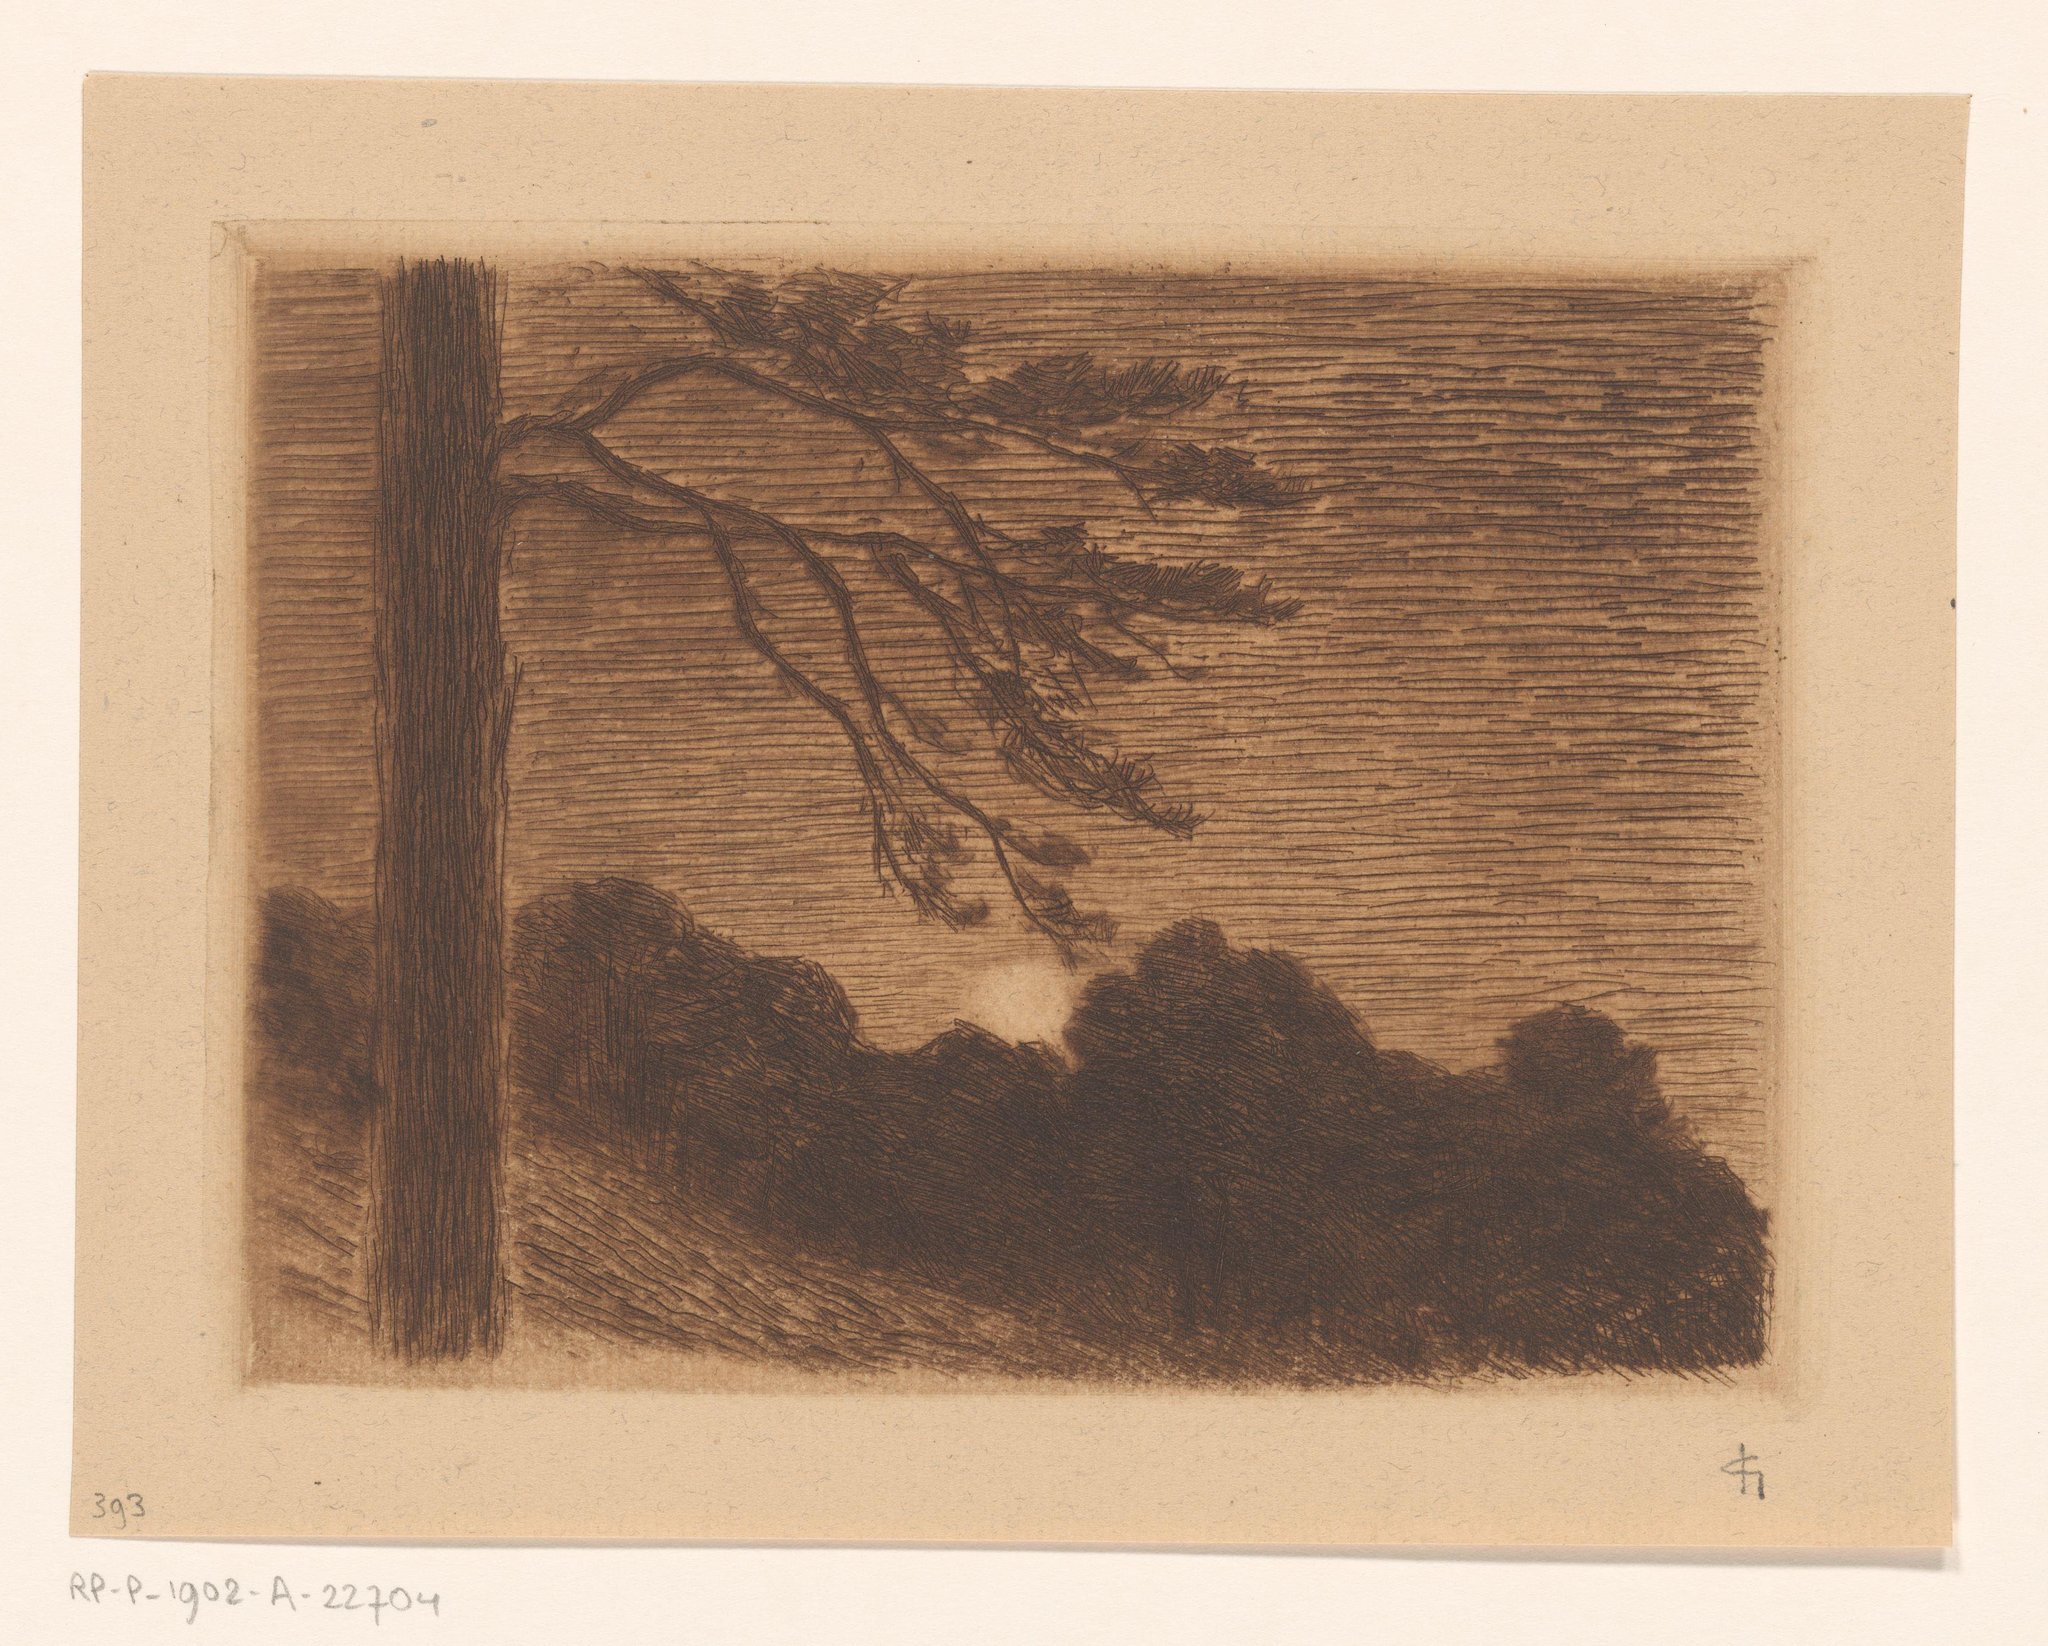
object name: print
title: Landschap met opkomende maan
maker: carel nicolaas storm van s-gravesande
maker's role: draughtsman, print maker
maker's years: 1841-1924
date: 1851-1902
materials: paper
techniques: drypoint, etching, intaglio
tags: moonrise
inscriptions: number: ‘393’, collector's mark: Lugt 2228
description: Mogelijk vermeld in: Storm van 's-Gravesande, Charles. Catalogue des eaux-fortes et lithographies. New York: s.n., 1903, of in een onbekende latere uitgave van het manuscript. Vermoedelijk vermeld als catalogusnummer 393.